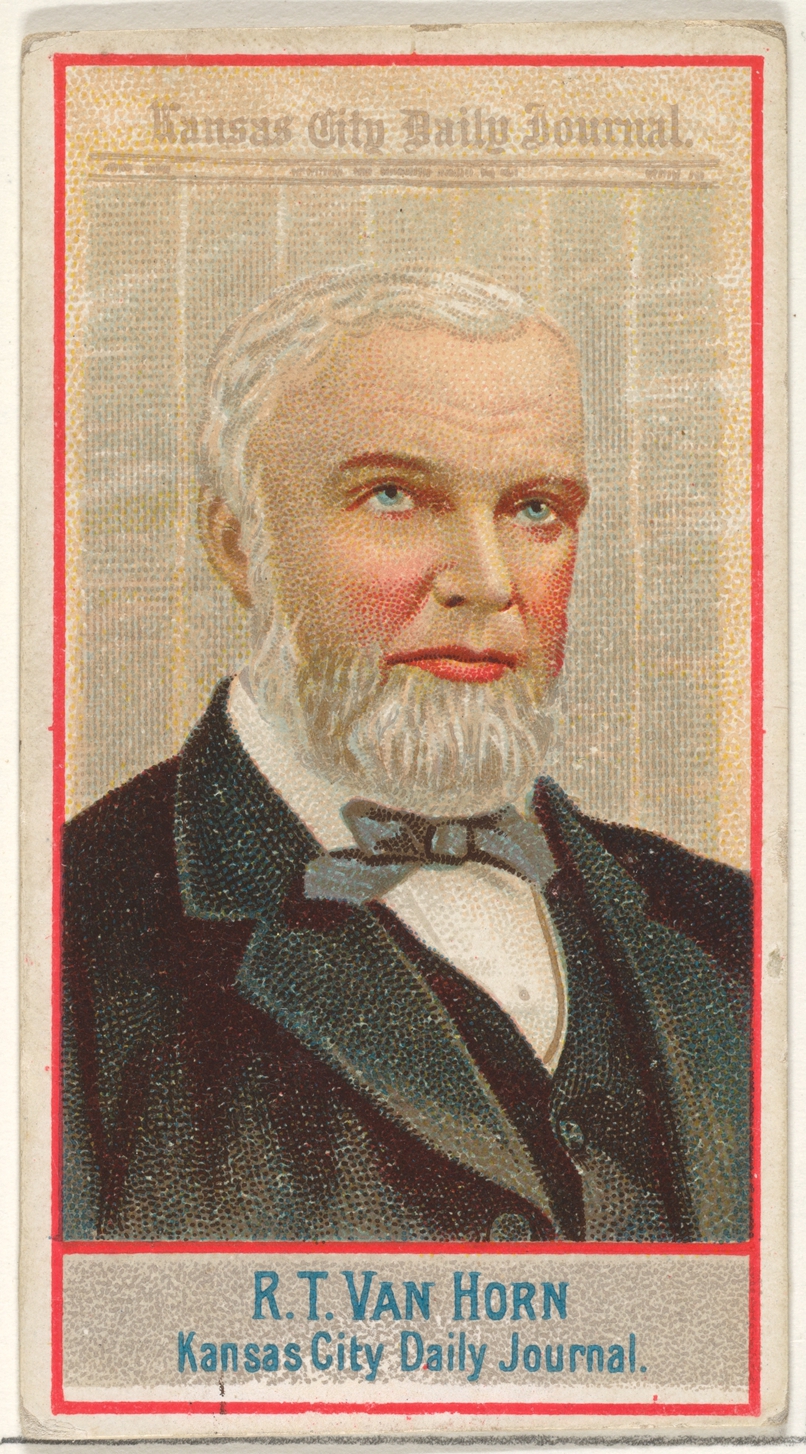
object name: print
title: R.T. Van Horn, Kansas City Daily Journal, from the American Editors series (N1) for Allen & Ginter Cigarettes Brands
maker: allen & ginter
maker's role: publisher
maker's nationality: american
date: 1887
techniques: color lithograph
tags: men,portraits